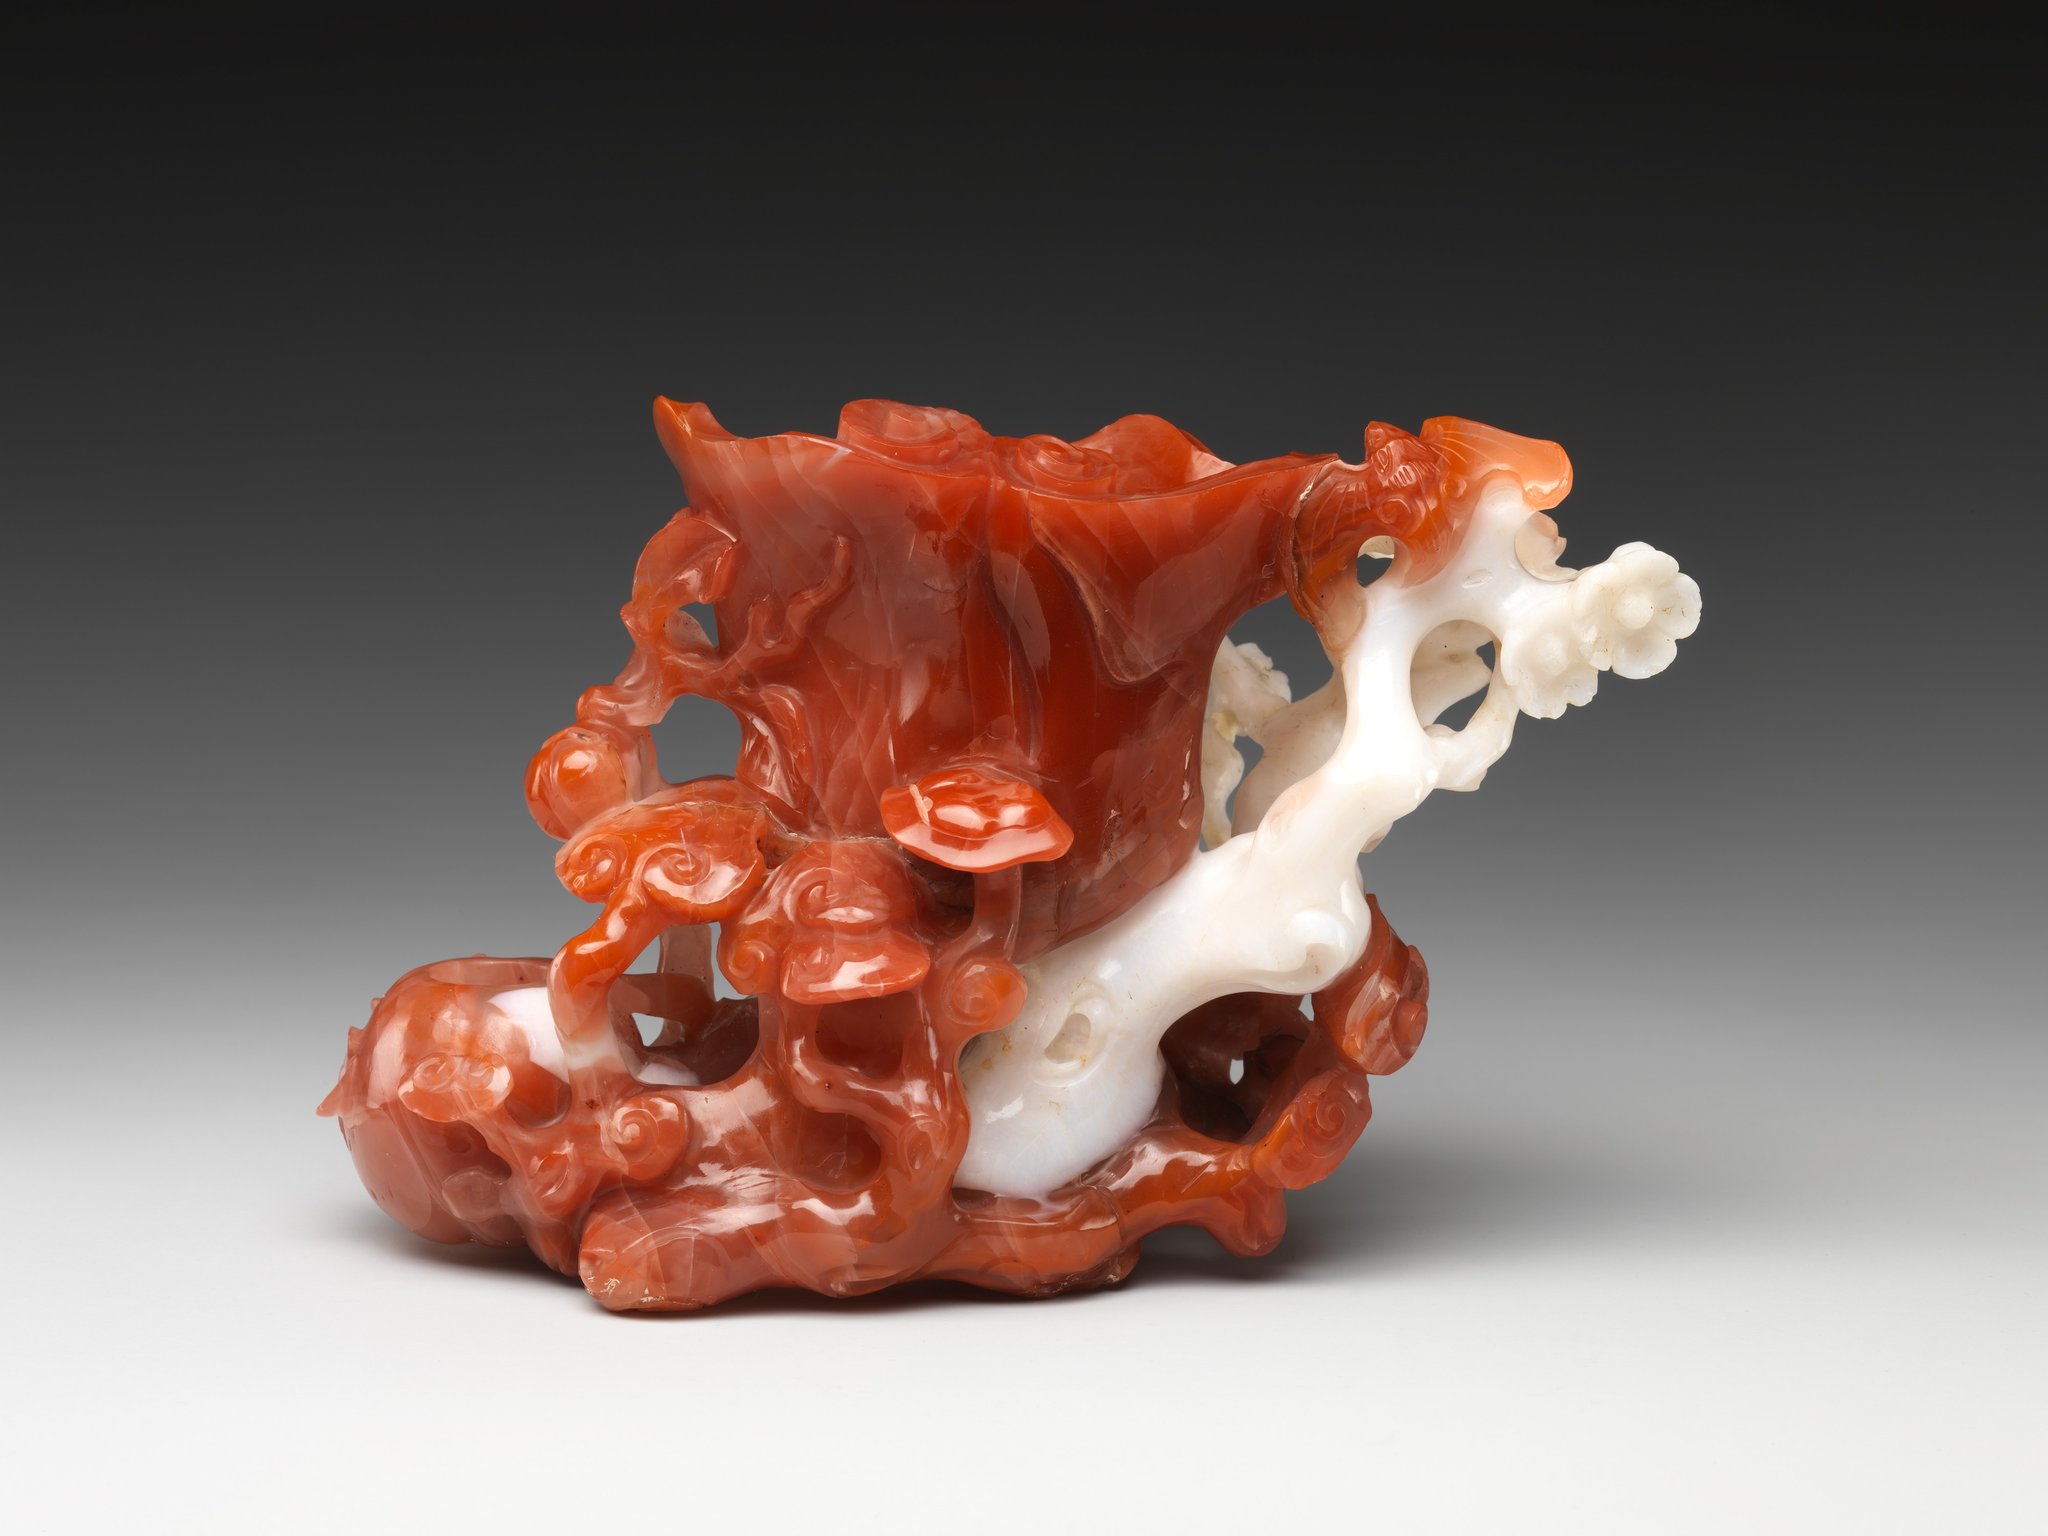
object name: flower holder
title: Flower holder with floral design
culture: chinese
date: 1701-1800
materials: stone, gemstone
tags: flowers